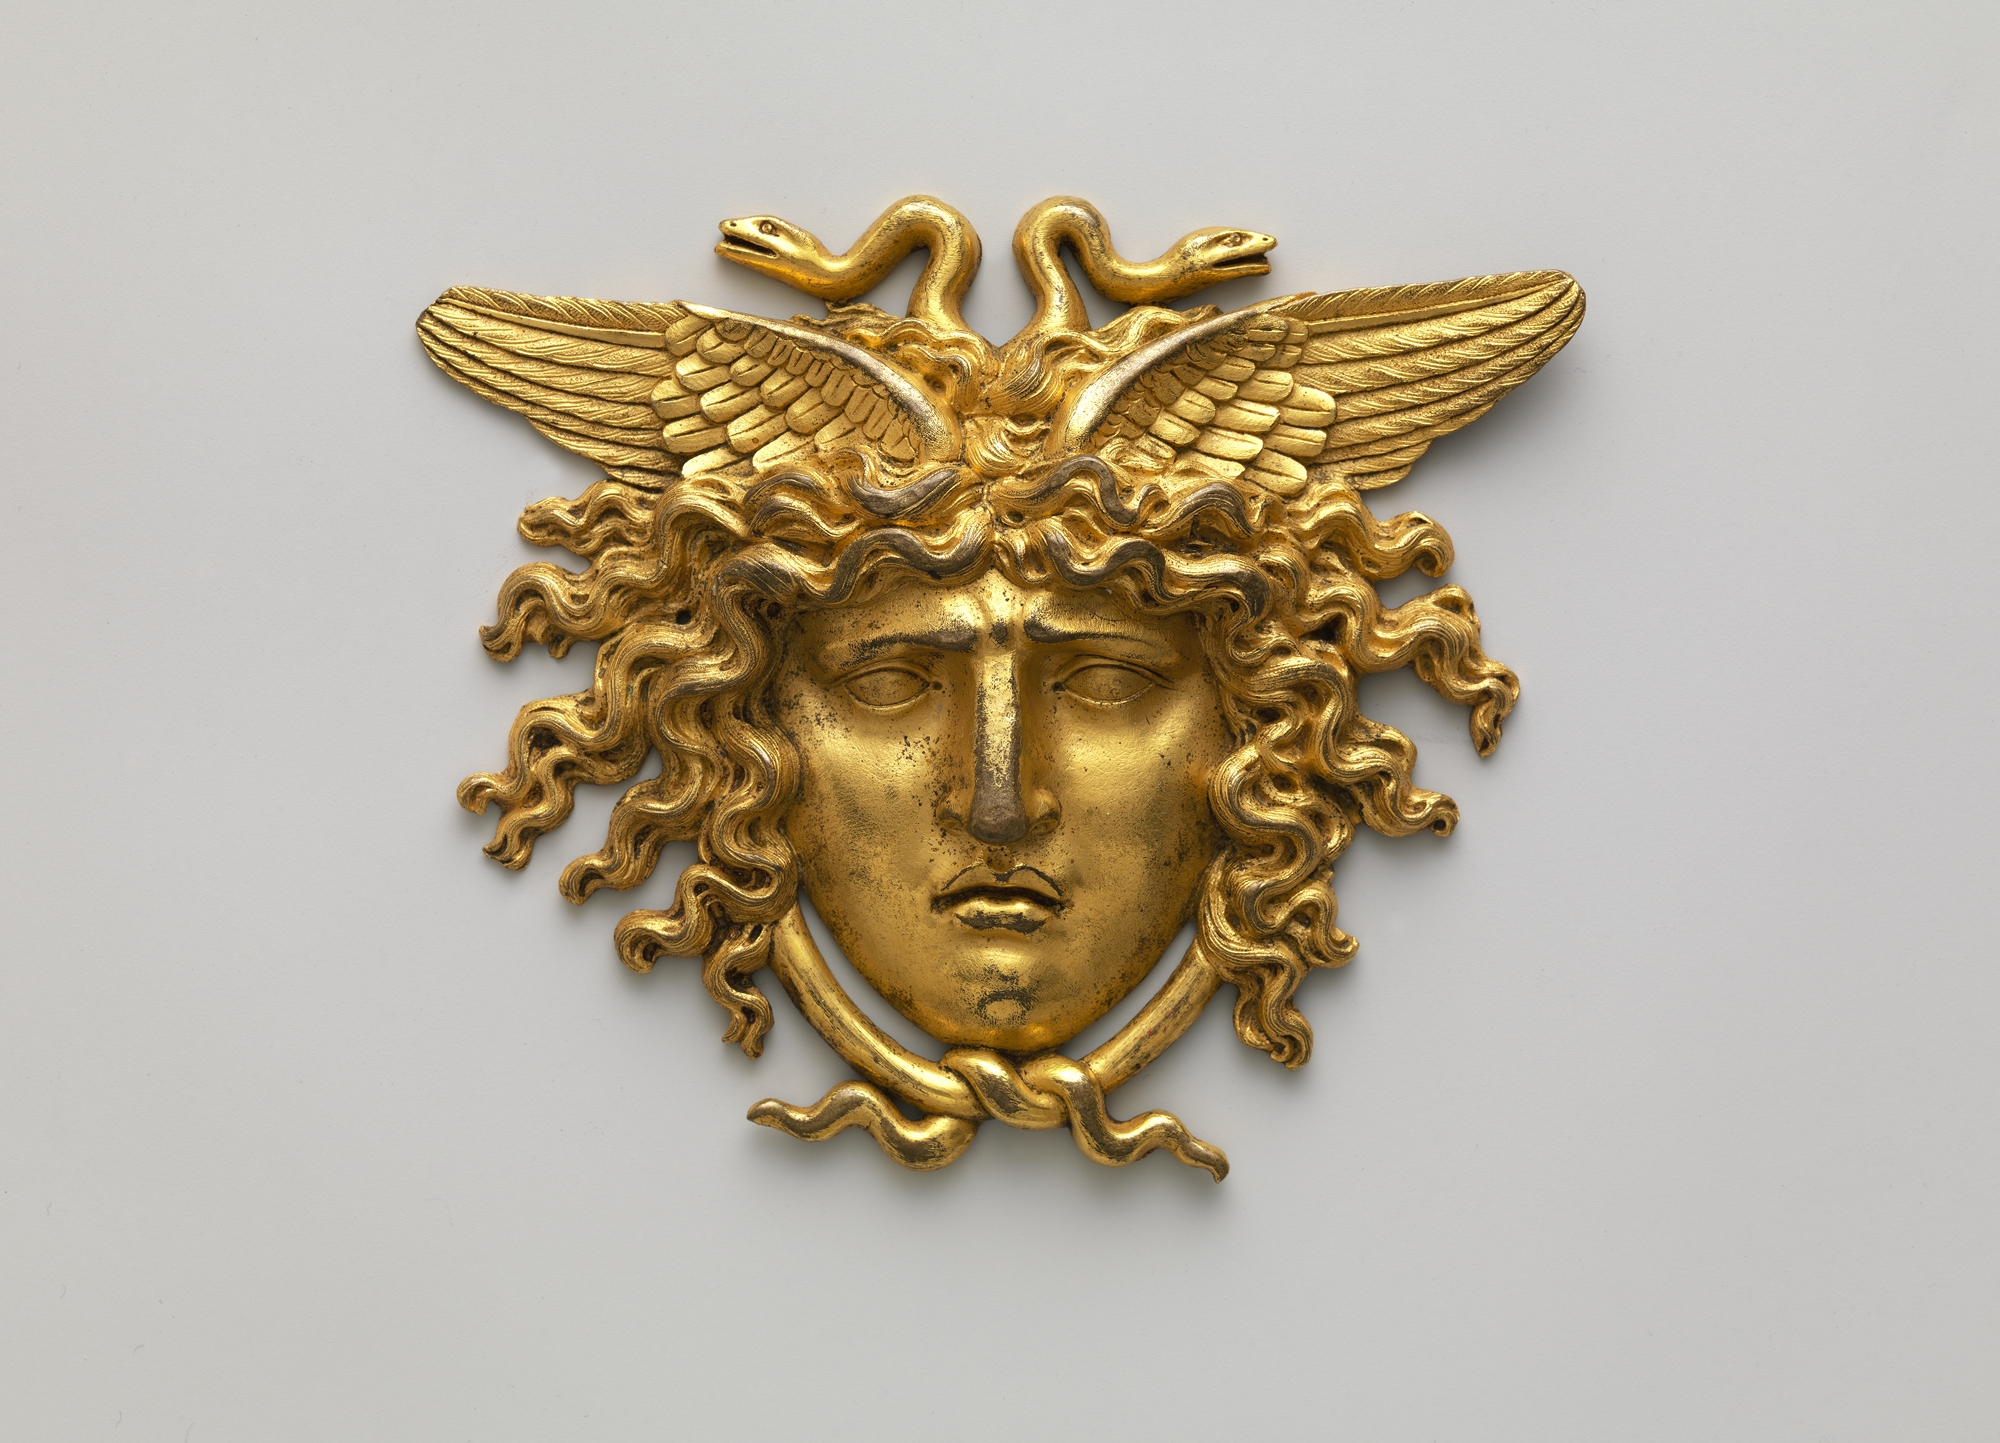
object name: panel ornament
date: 1801-1900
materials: gilt bronze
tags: faces